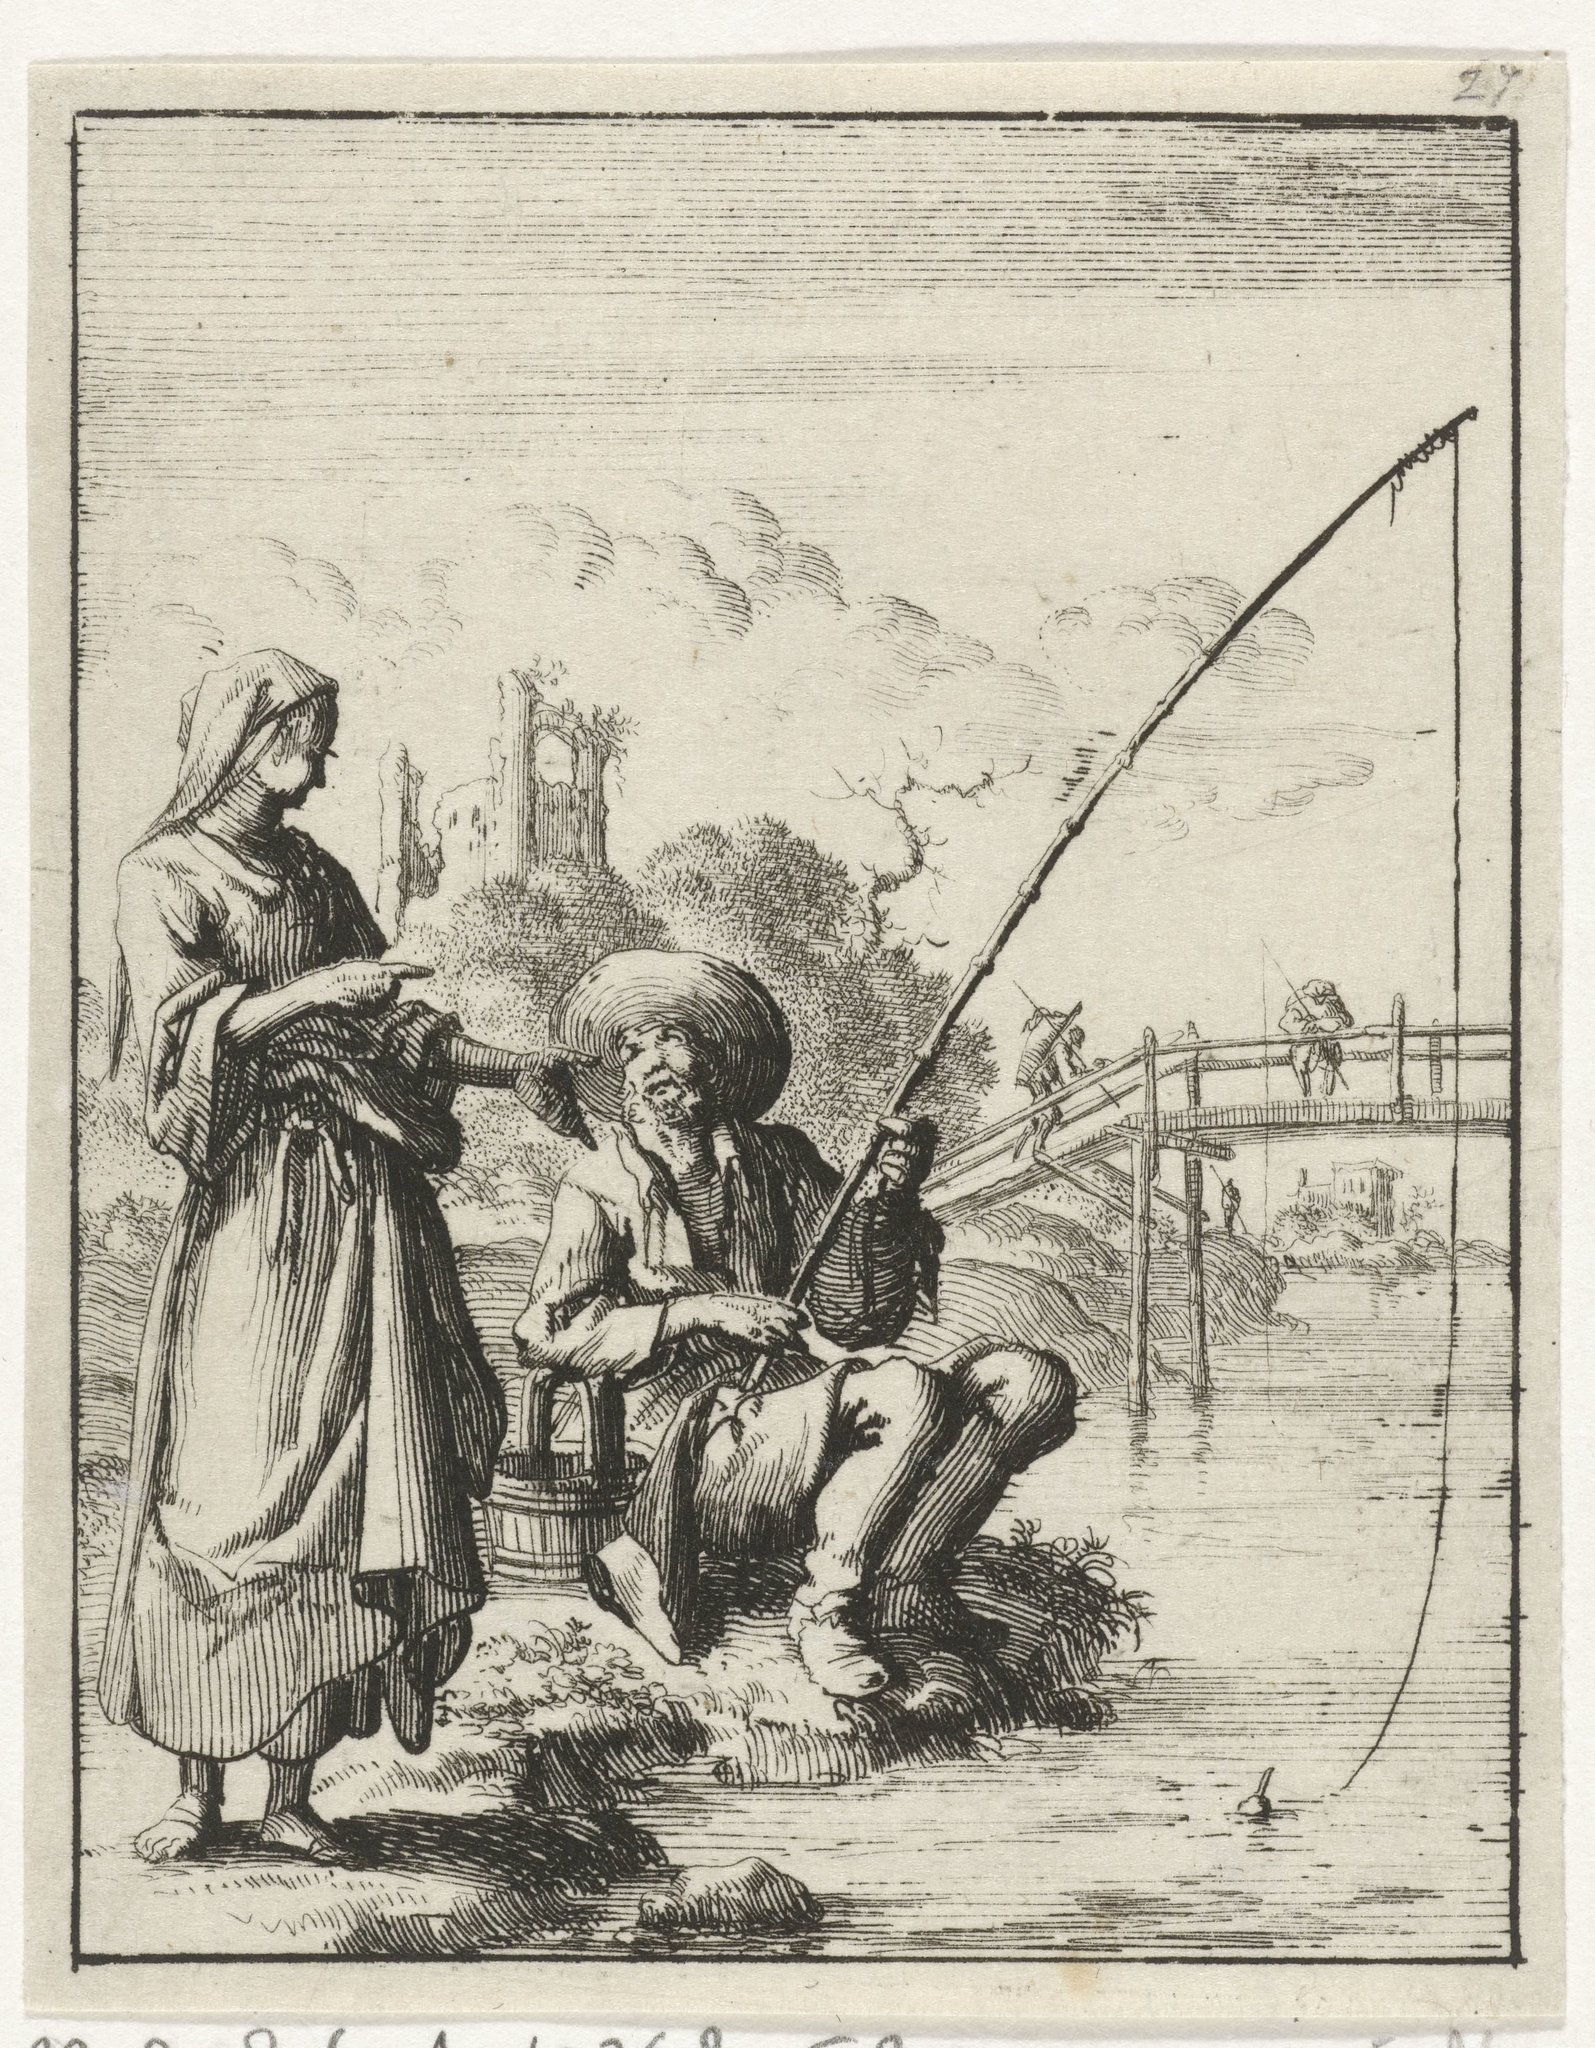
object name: print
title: Schyn bedriegt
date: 1687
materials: paper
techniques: etching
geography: amsterdam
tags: conversation, dialogue; conversation piece, fisherman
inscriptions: number: ‘27’, collector's mark: Lugt 2228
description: Illustratie uit: Luyken, Jan. Voncken der liefde Jesu, van het godtbegerende zielenvier. Amsterdam: Pieter Arentsz (II), 1687, p. 110.